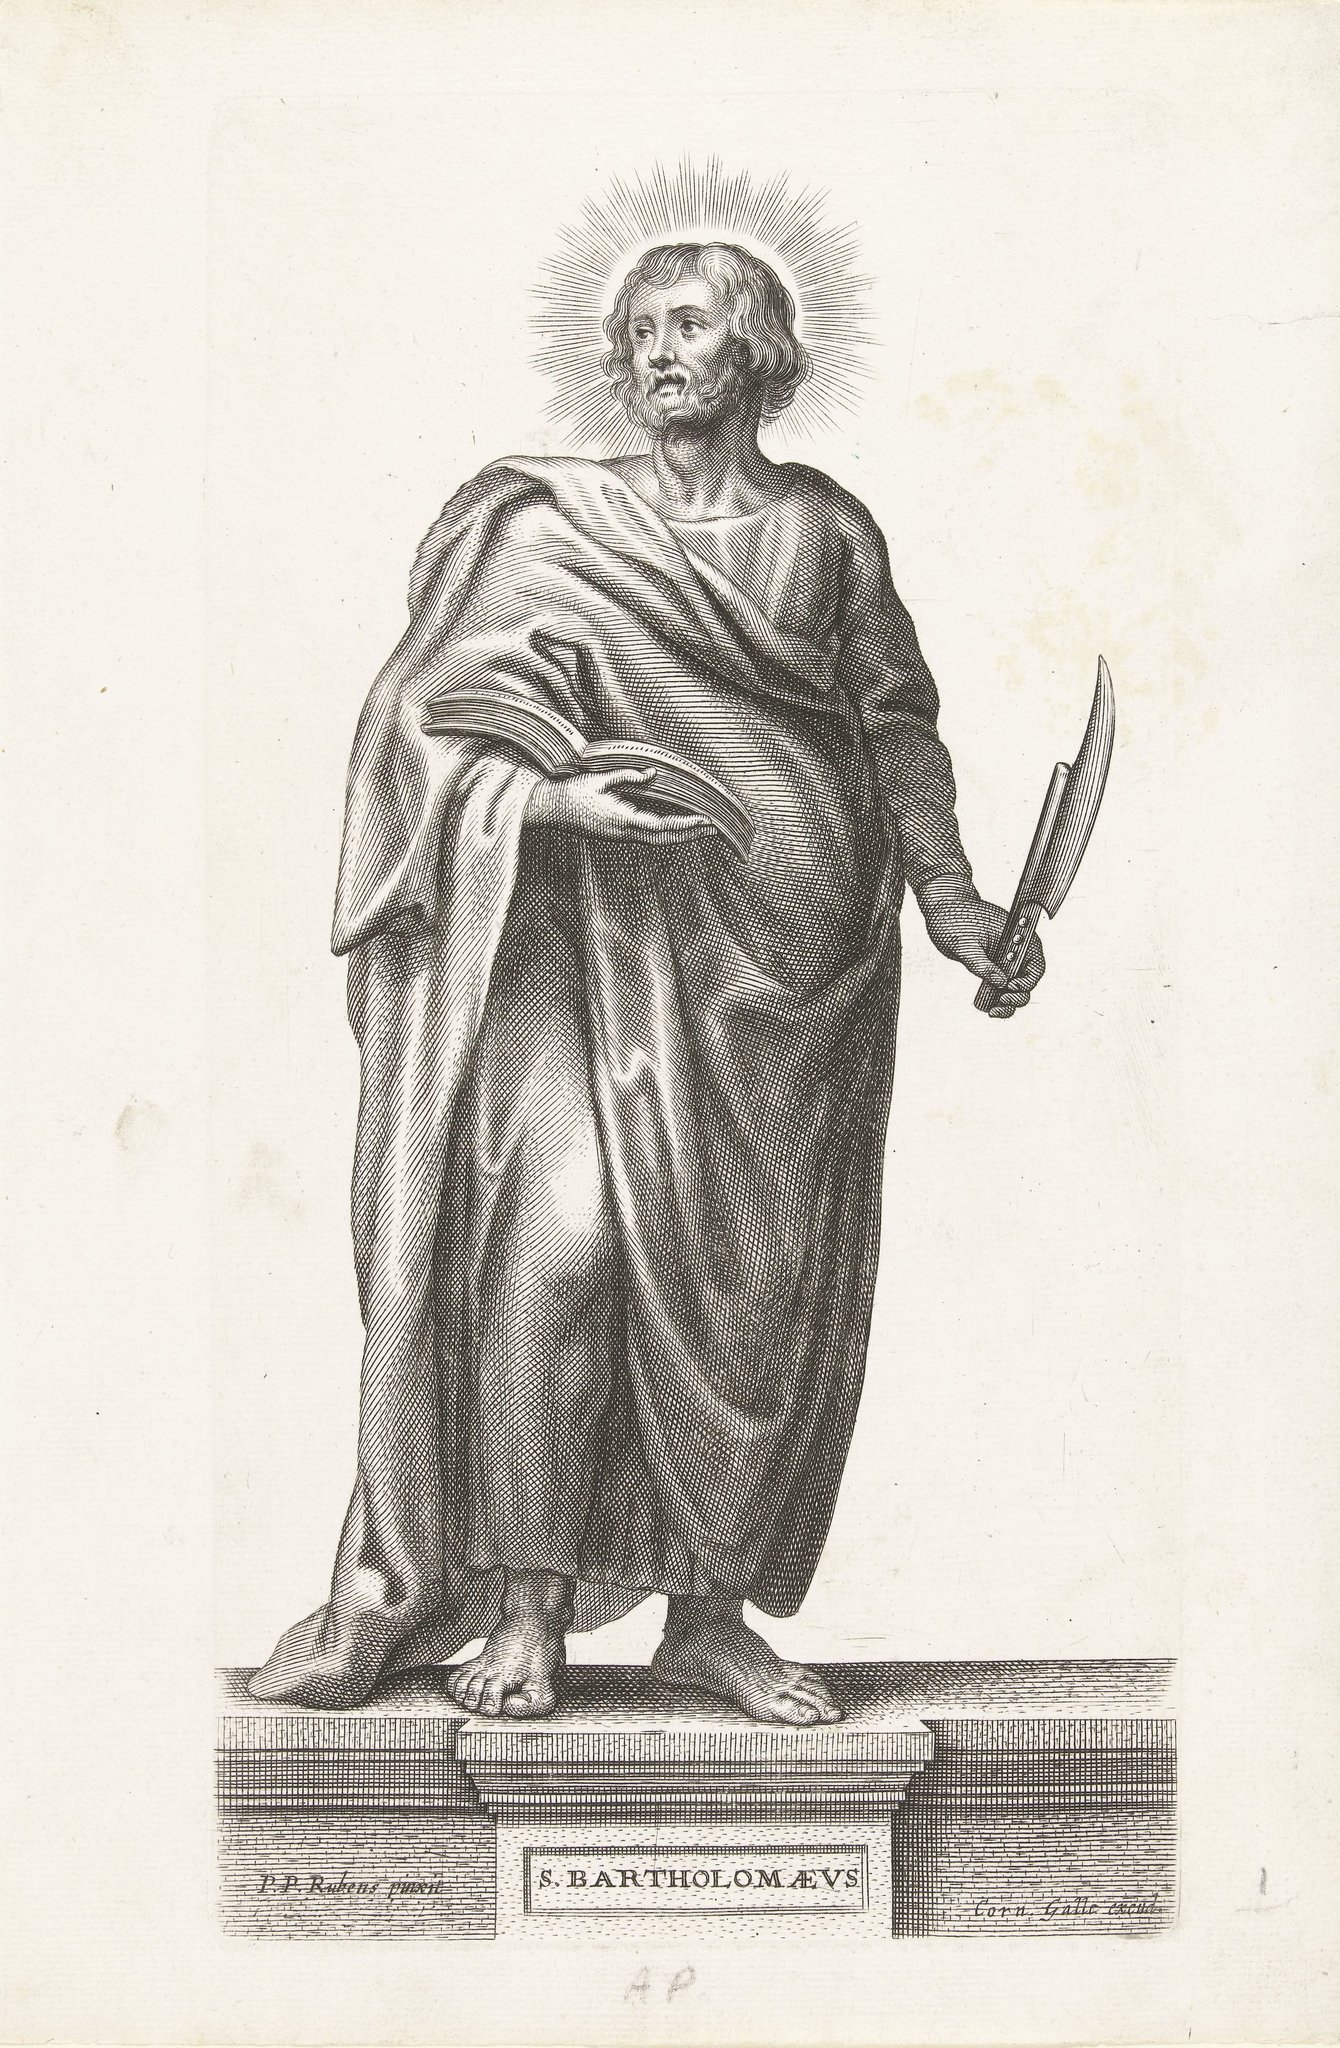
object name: print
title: SS Apostolorum Iconen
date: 1639-1670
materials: paper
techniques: engraving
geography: antwerp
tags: the apostle bartholomew; possible attributes: book, devil or dragon at feet, knife, scroll, flayed skin, staff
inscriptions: collector's mark: Lugt 2228, collector's mark: Lugt 2760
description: De prent toont de Heilige Bartholomeus. In zijn linkerhand het mes waarmee hij werd gevild. De serie bestaat uit prenten gebaseerd op schilderijen van Peter Paul Rubens.